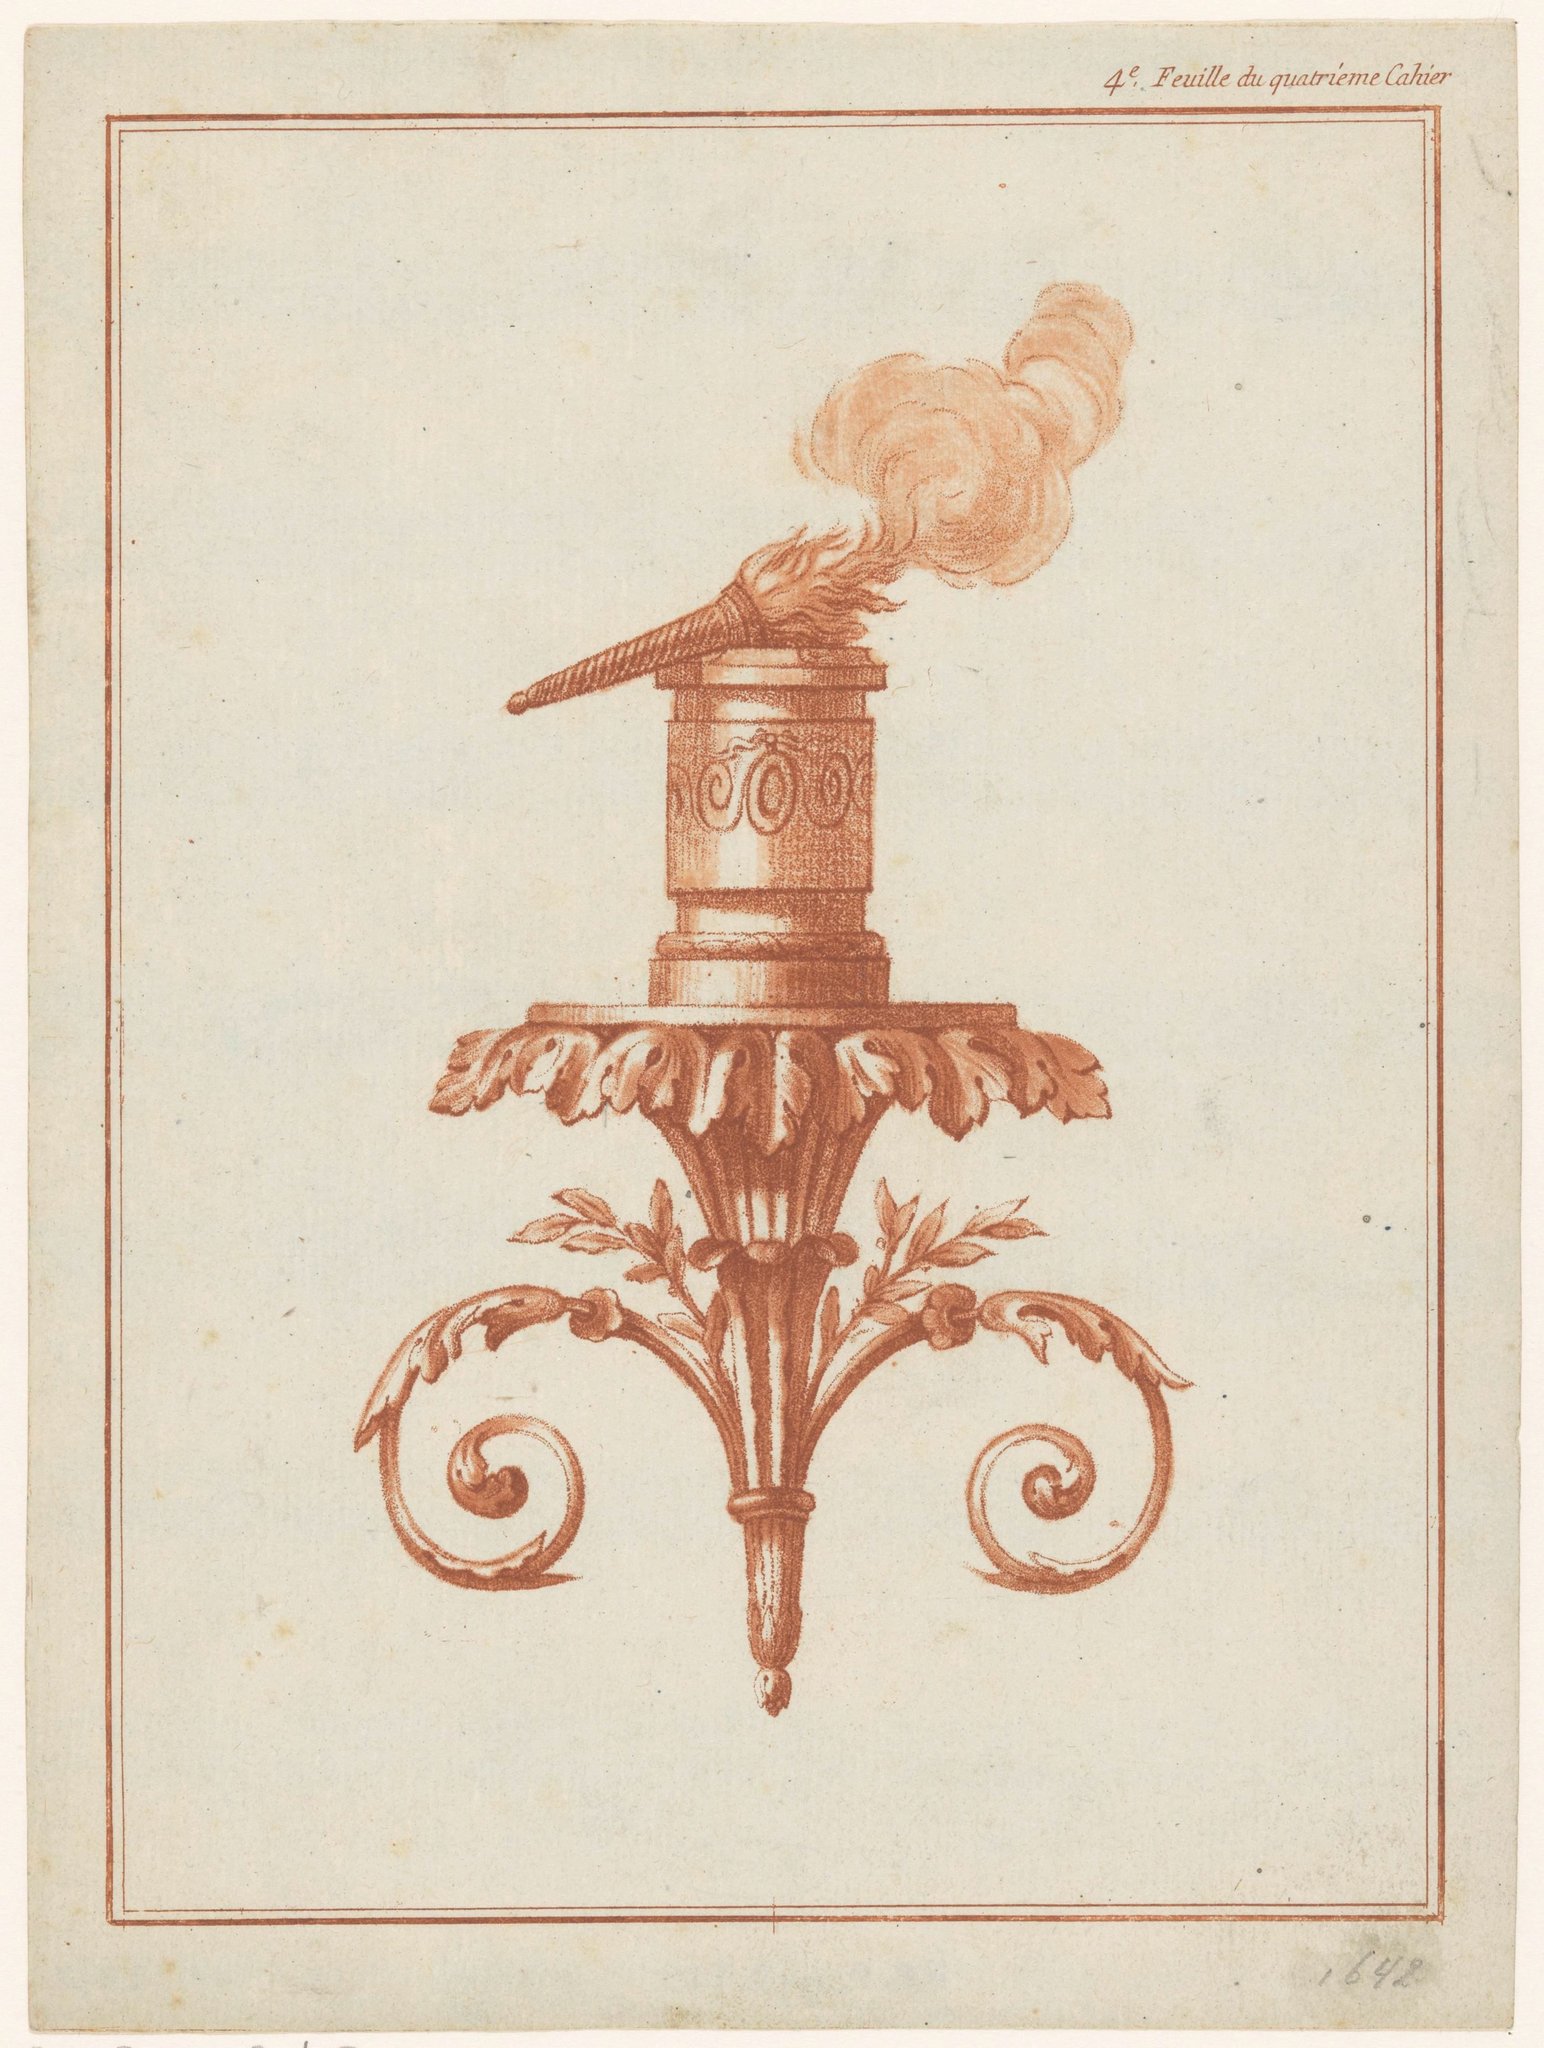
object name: ornament print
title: Console met fakkel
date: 1770-1780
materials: paper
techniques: printmaking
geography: paris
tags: torch, other architectural details (console)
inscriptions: collector's mark: Lugt 2228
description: Console waarop een brandende fakkel ligt.